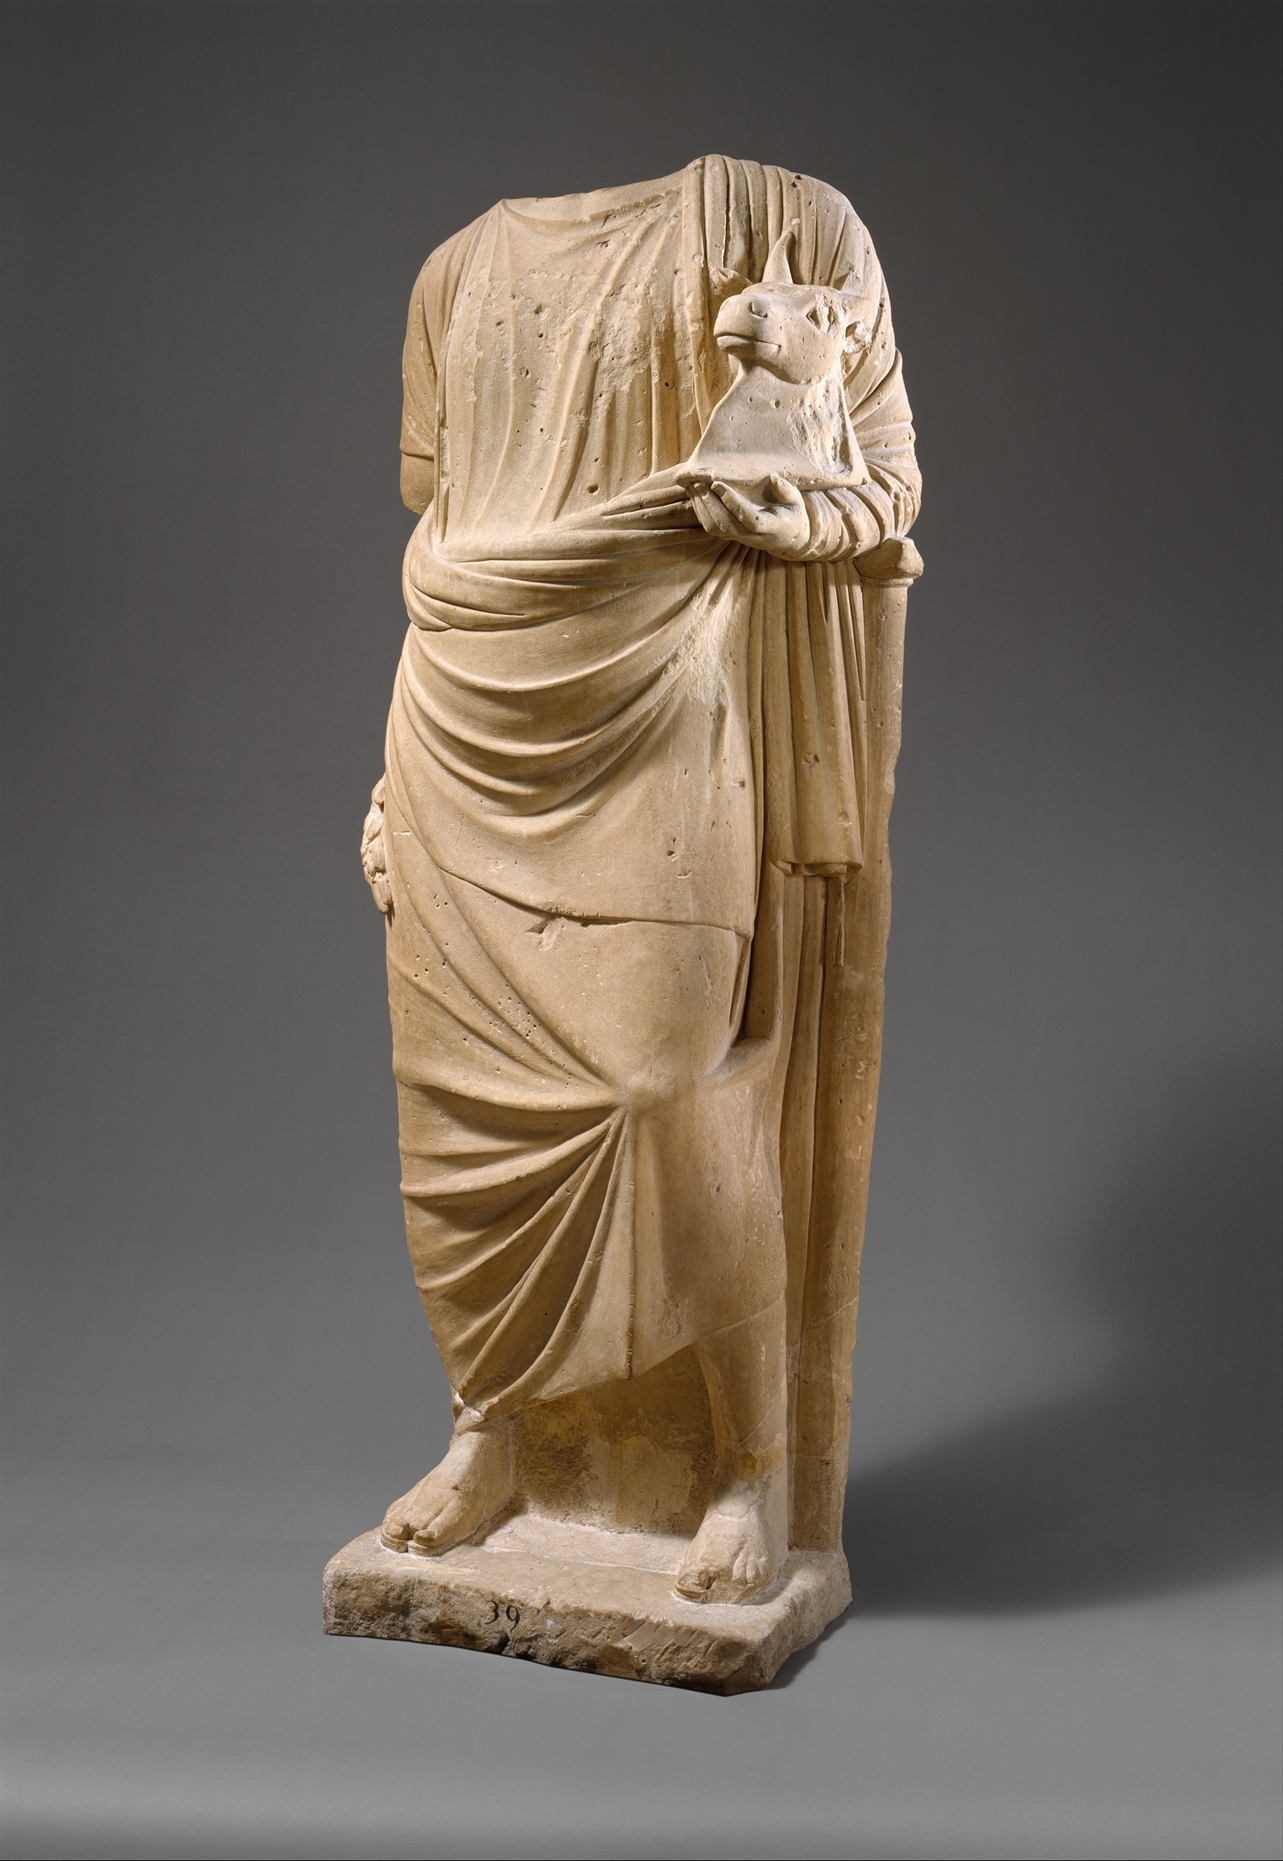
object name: statue of a man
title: Limestone statue of a man holding a mask in the form of a bull's head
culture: cypriot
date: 350-301 BCE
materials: limestone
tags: masks,men,bulls